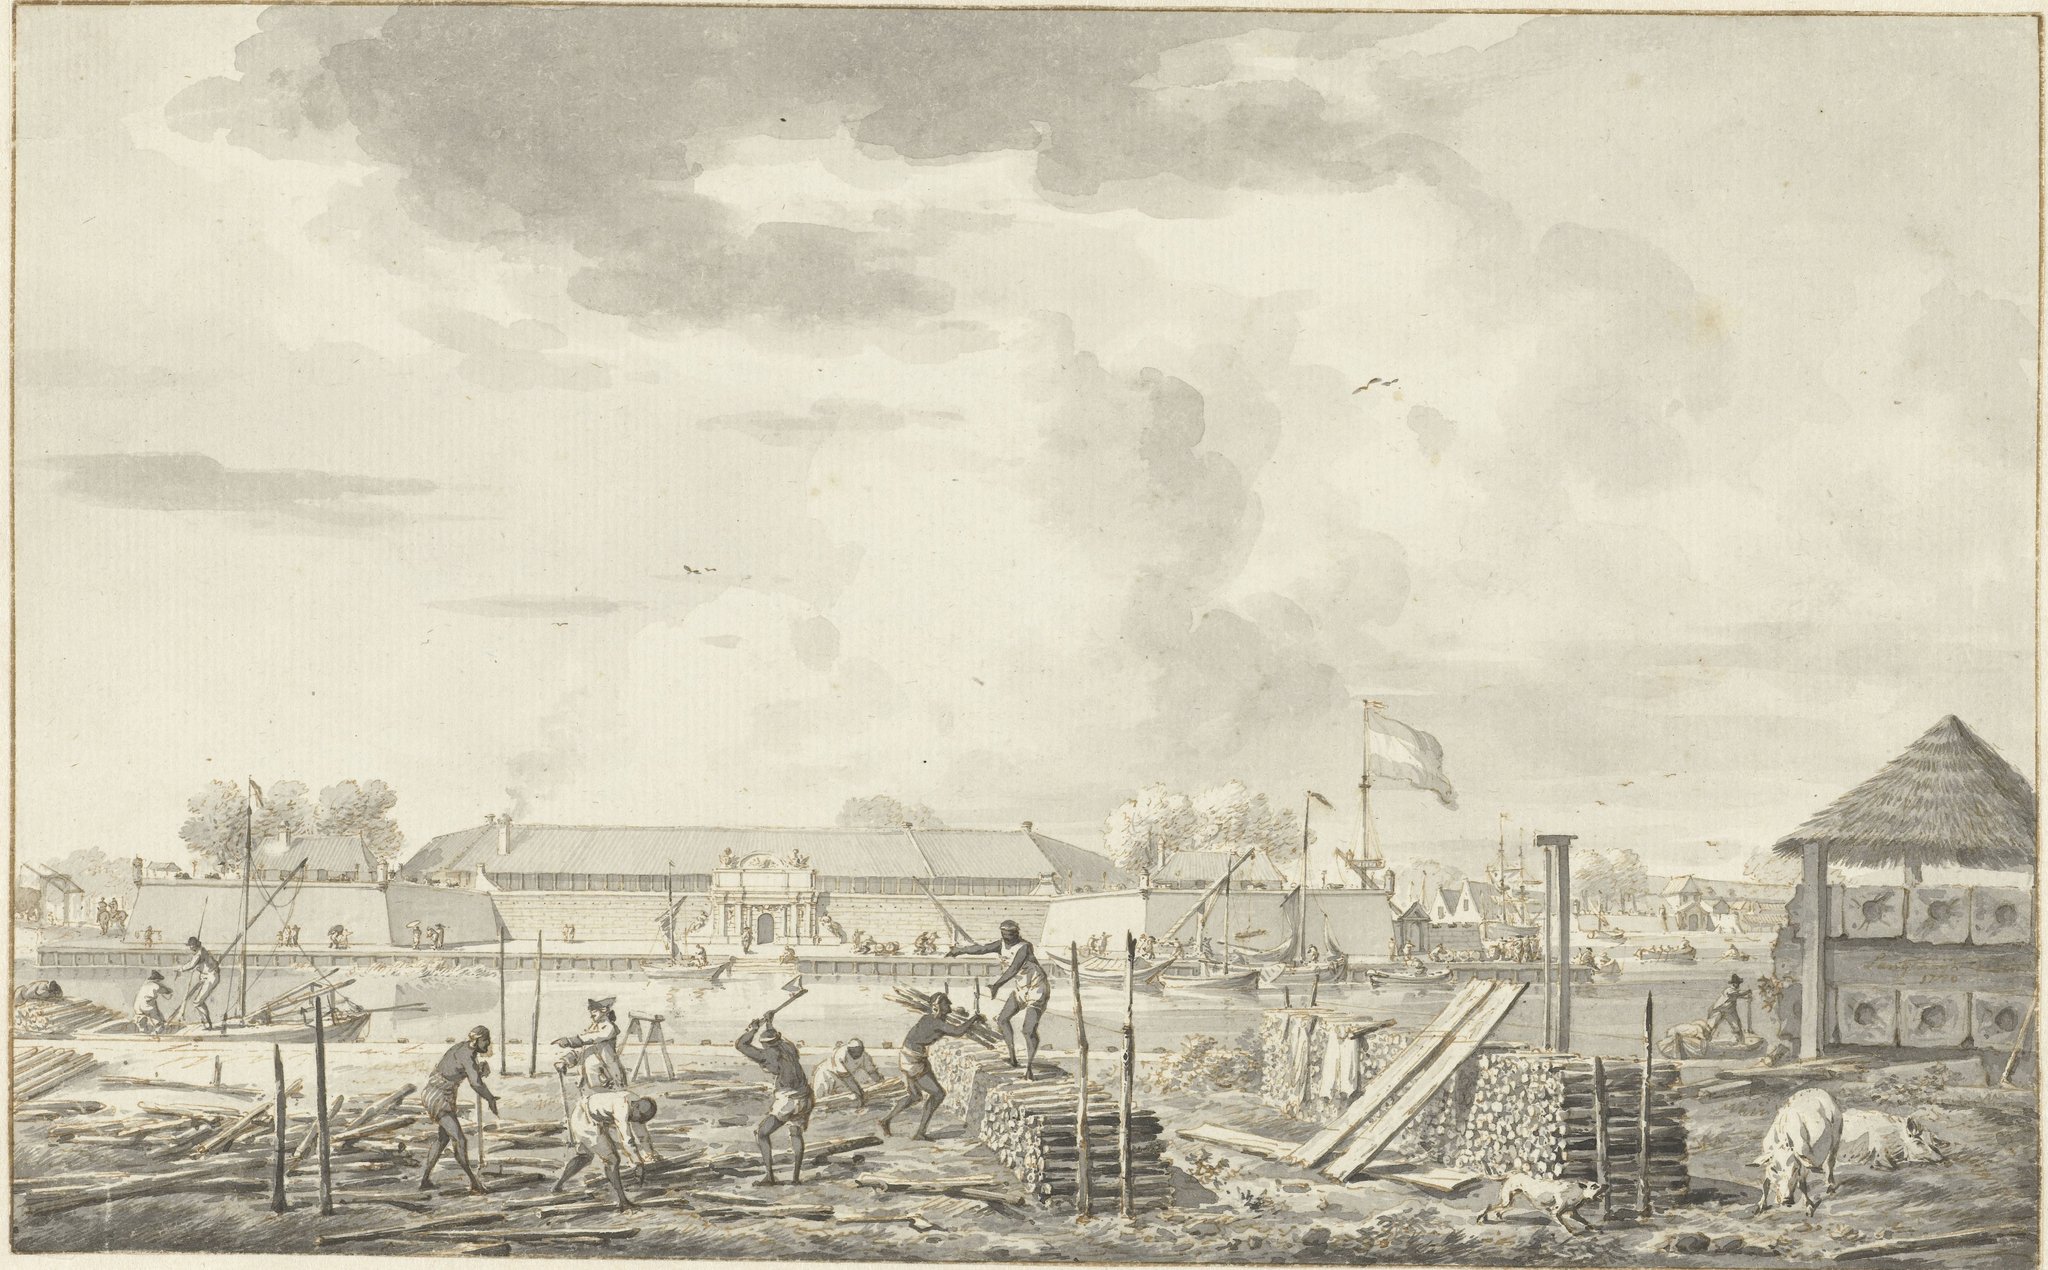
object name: drawing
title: Het Kasteel te Batavia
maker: dirk langendijk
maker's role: draughtsman, painter, print maker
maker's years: 1748-1805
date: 1780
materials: ink, paper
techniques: brush, pen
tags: fortress, public road, batavia, indonesia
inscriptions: date: ‘1780’